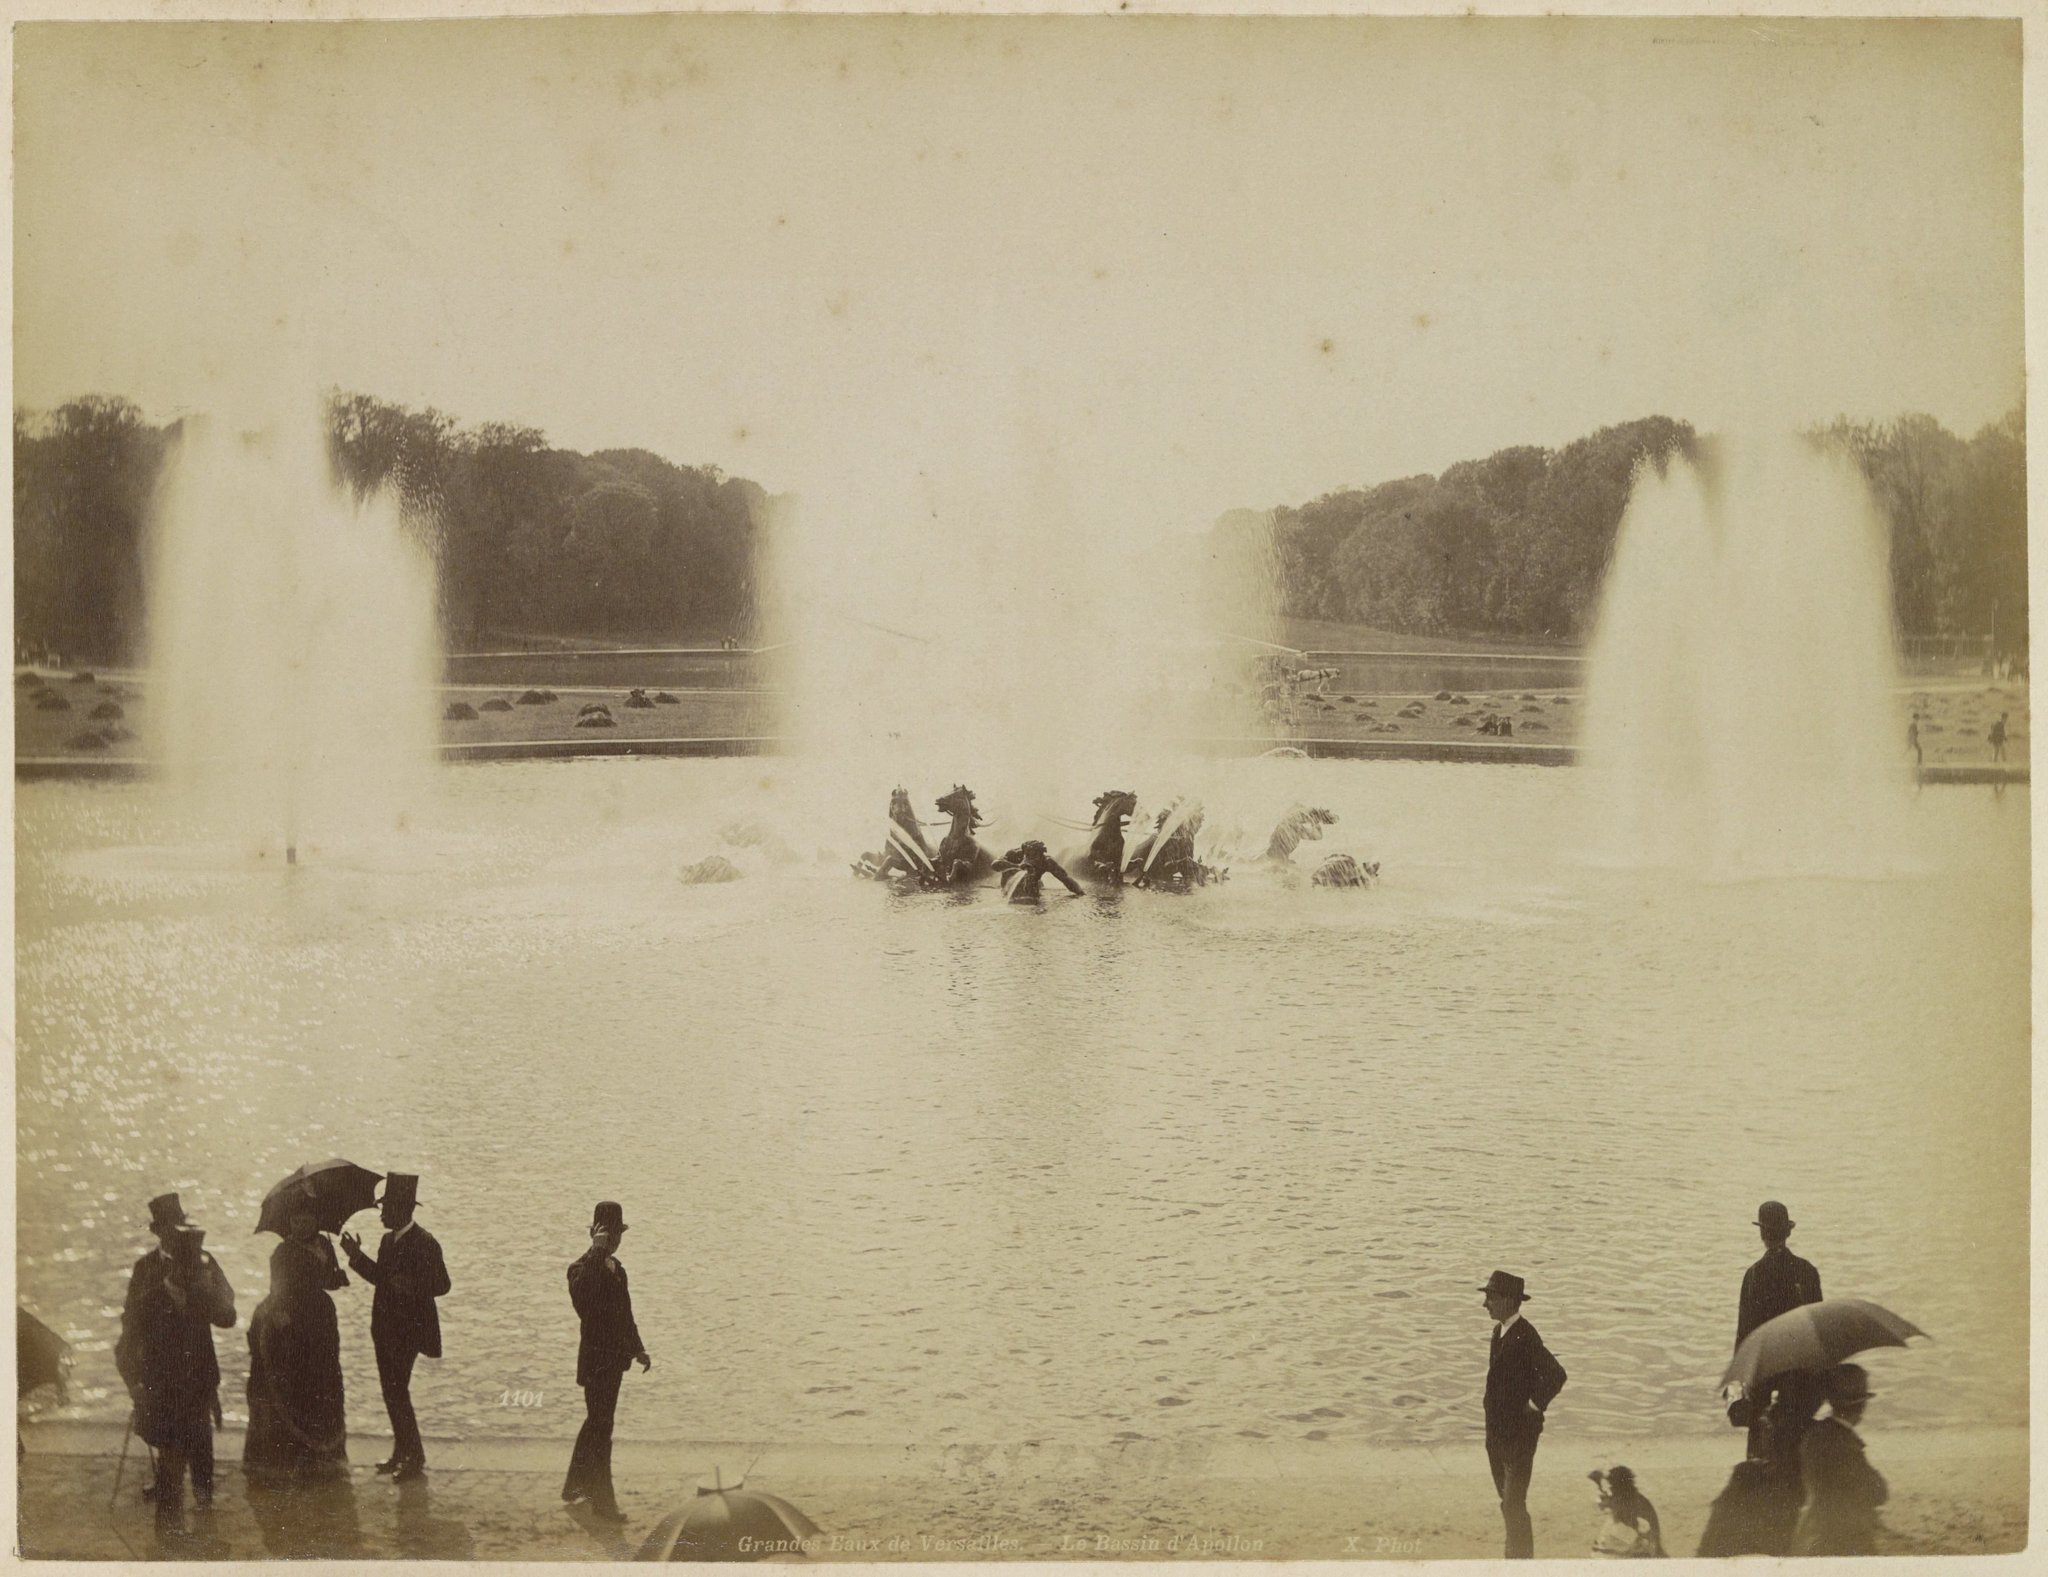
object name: photograph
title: Grandes Eaux de Versailles. - Le Bassin d'Apollon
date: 1880-1890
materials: paper, photographic support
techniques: albumen print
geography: versailles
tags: ornamental fountain (+ city(-scape) with figures, staffage)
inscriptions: negative number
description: Onderdeel van Reisalbum met foto's van bezienswaardigheden in Frankrijk, Griekenland en Turkije.